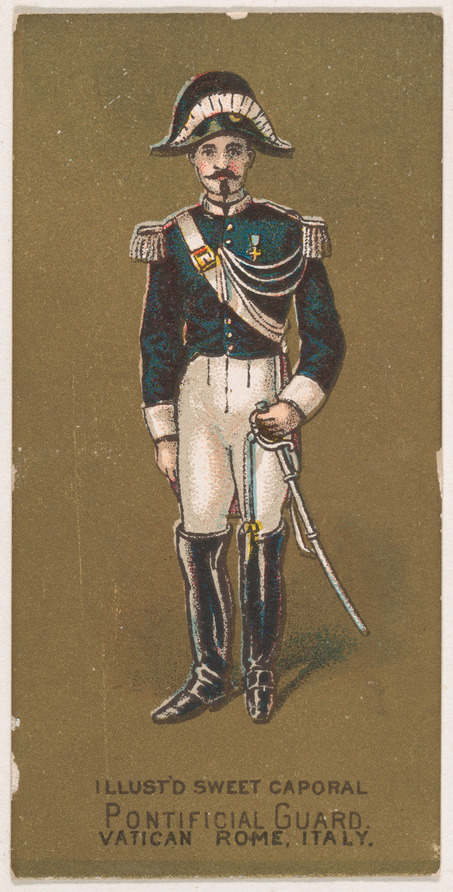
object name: print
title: Pontificial Guard, Vatican, Rome, Italy, from the Military Series (N224) issued by Kinney Tobacco Company to promote Sweet Caporal Cigarettes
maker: kinney brothers tobacco company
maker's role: publisher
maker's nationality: american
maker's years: 1869-2011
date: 1888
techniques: color lithograph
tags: military,men